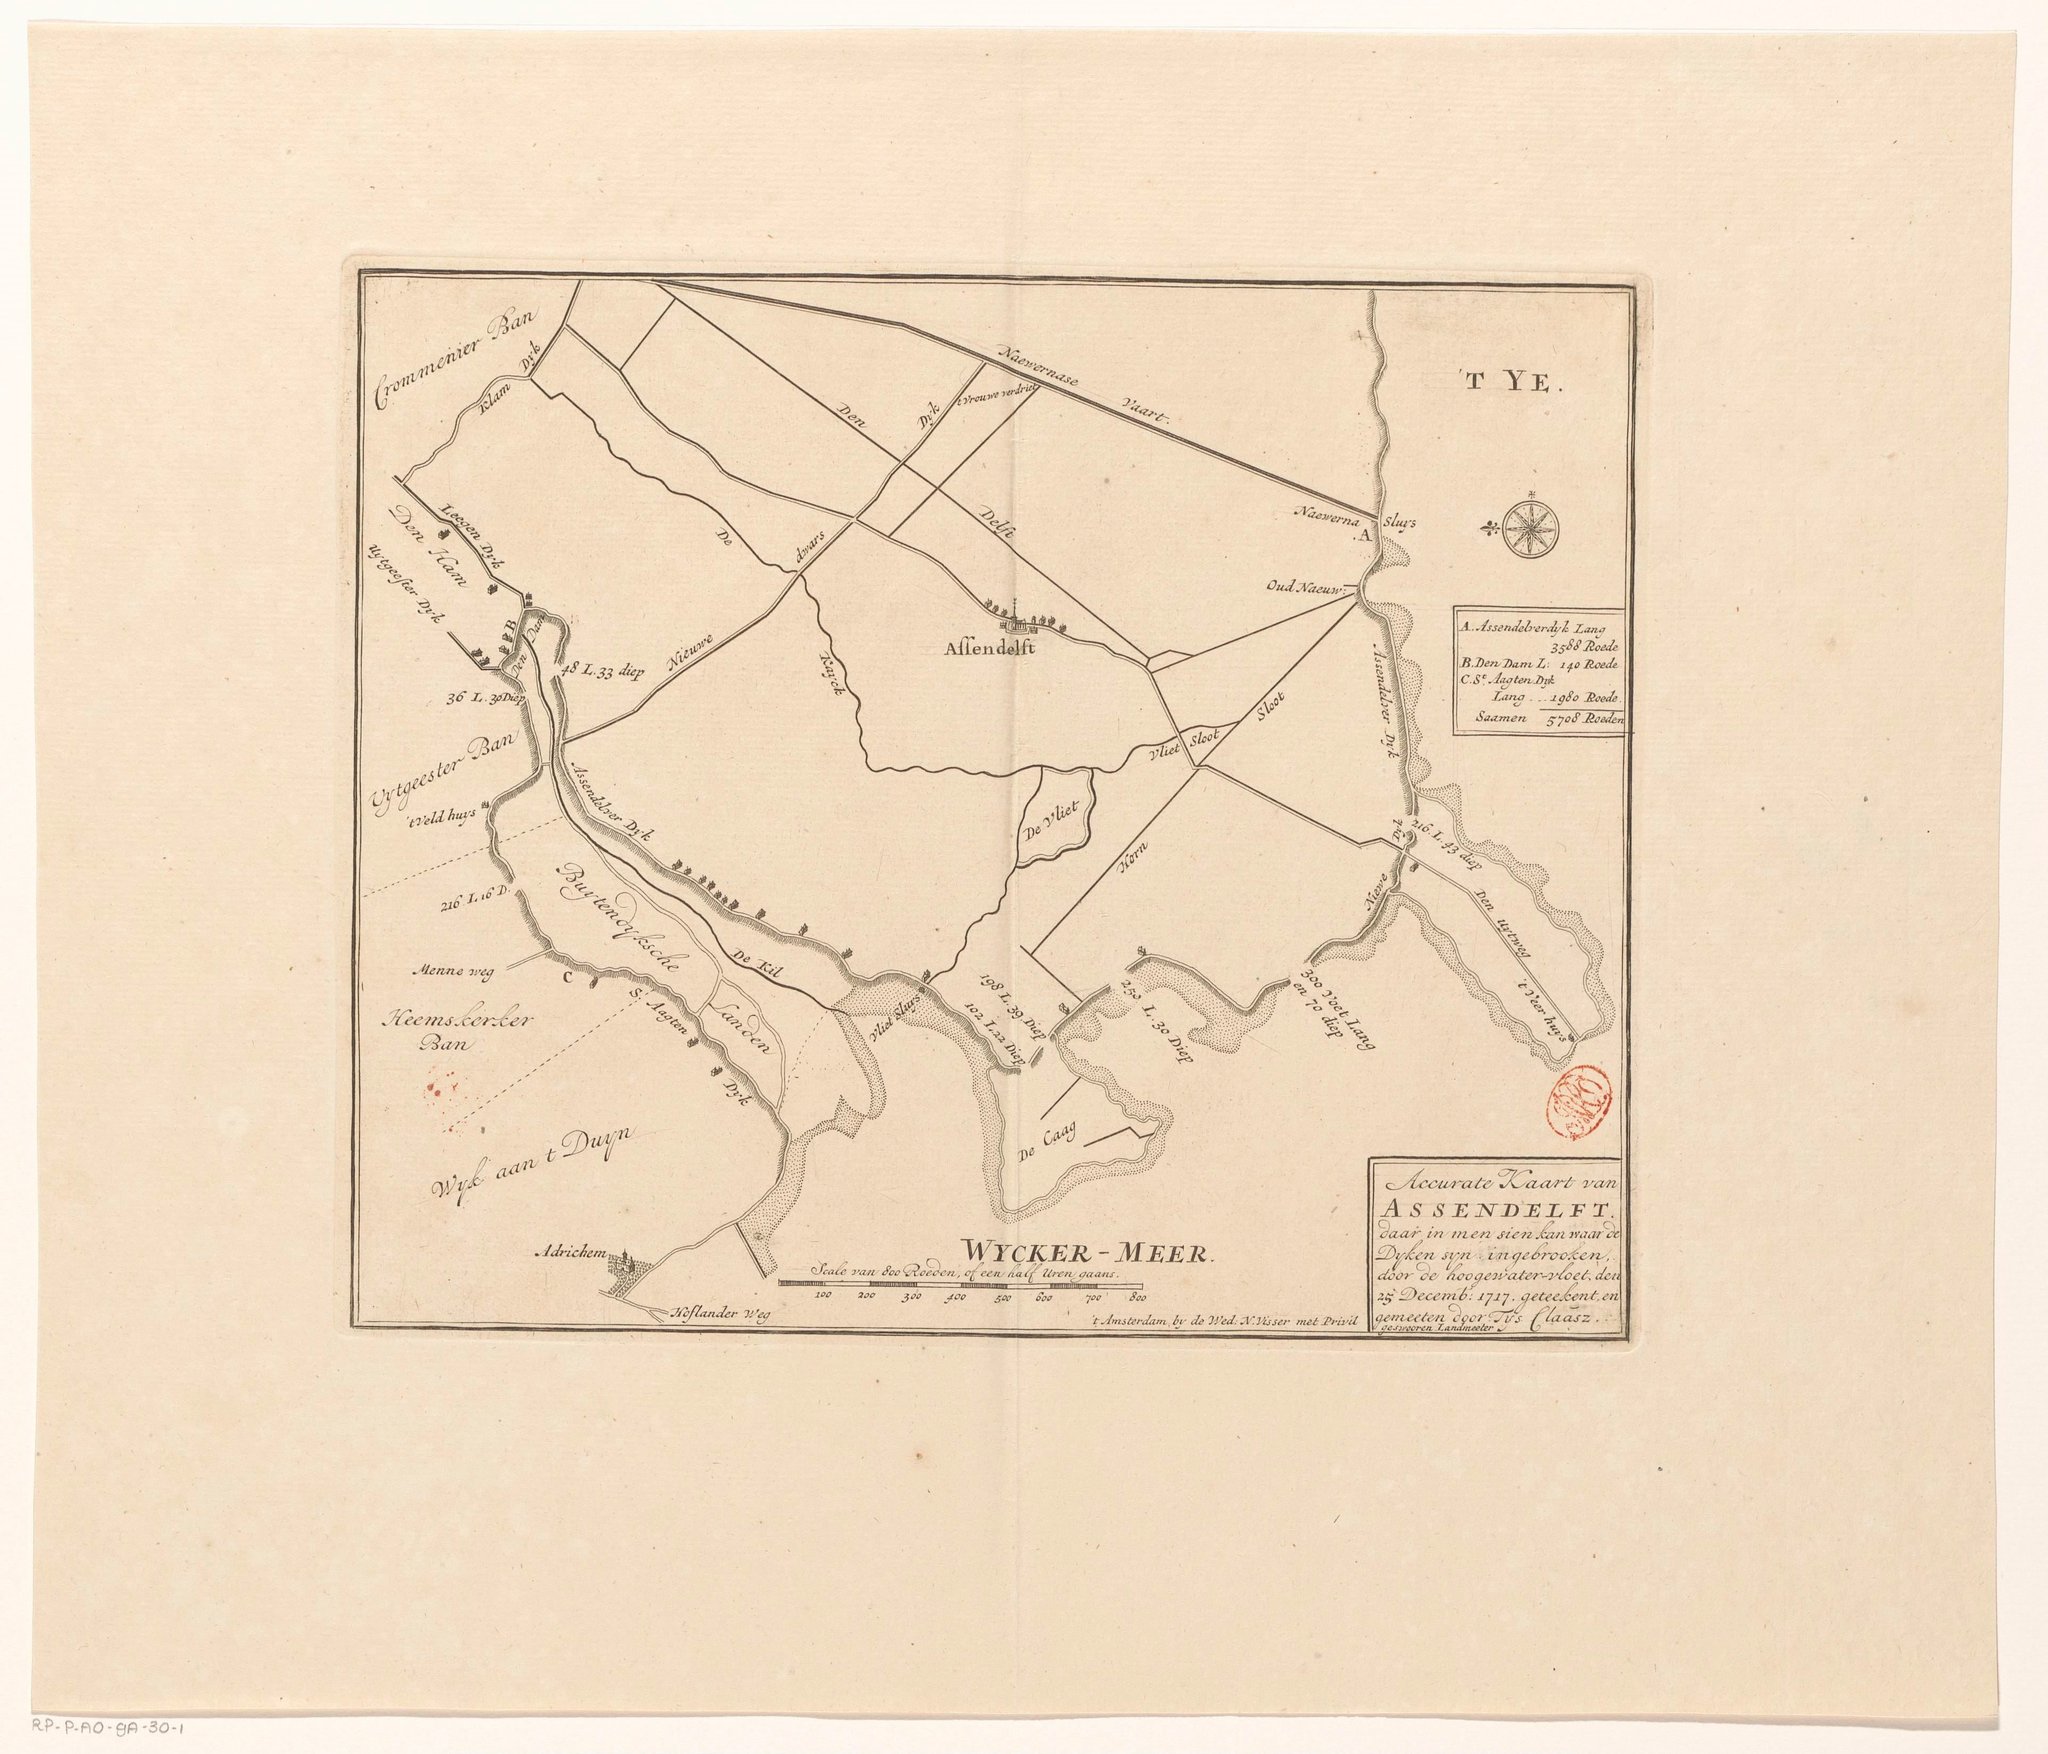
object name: print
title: Accurate kaart van Assendelft. Daar in men sien kan waar de dyken syn ingebrooken, door de hoogewater-vloet. Den 25 decemb: 1717 …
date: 1718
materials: paper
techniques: engraving, etching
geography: amsterdam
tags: dike-break, storm, maps of cities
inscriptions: collector's mark: Lugt 195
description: Kaart van Assendelft waarop de dijkdoorbraken veroorzaakt door de Kerstvloed van 1717 te zien zijn. Onderaan in het midden een schaalstok: Scale van 800 roeden, of een half uren gaans. Rechts een legenda A-C, rechtsonder de titel.